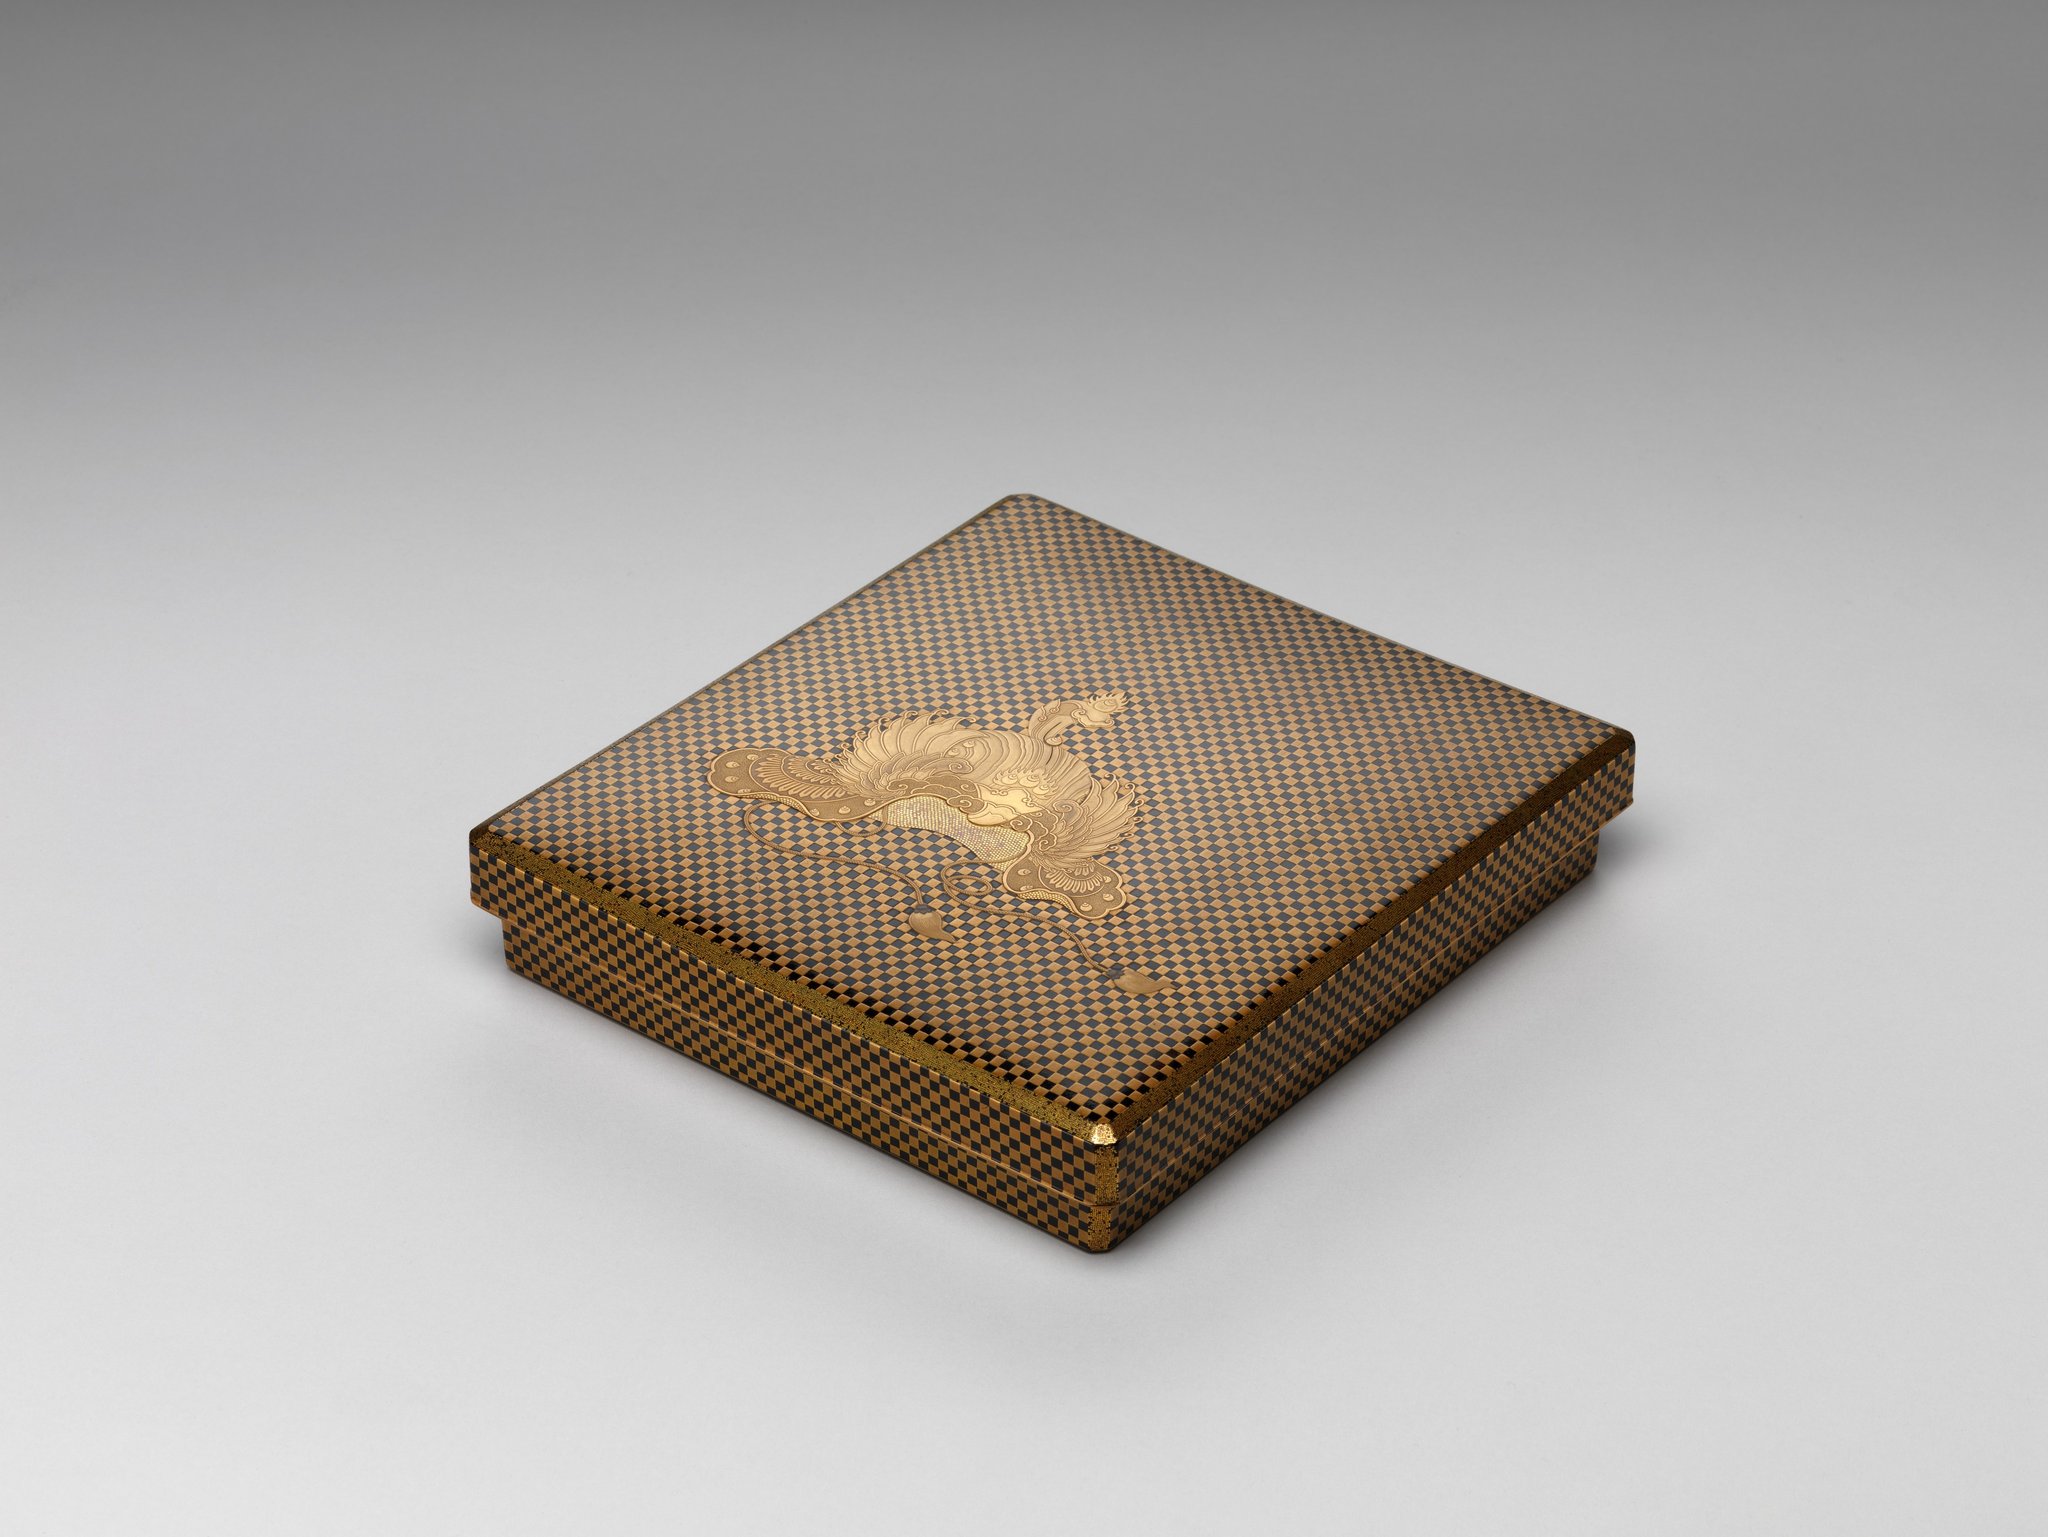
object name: writing box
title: Box for Square Calligraphy Paper (shikishi-bako) with a Bugaku Helmet on Checkered Ground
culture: japanese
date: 1701-1800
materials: gold, gold foil, lacquer, wood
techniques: hiramakie, lacquer, maki-e